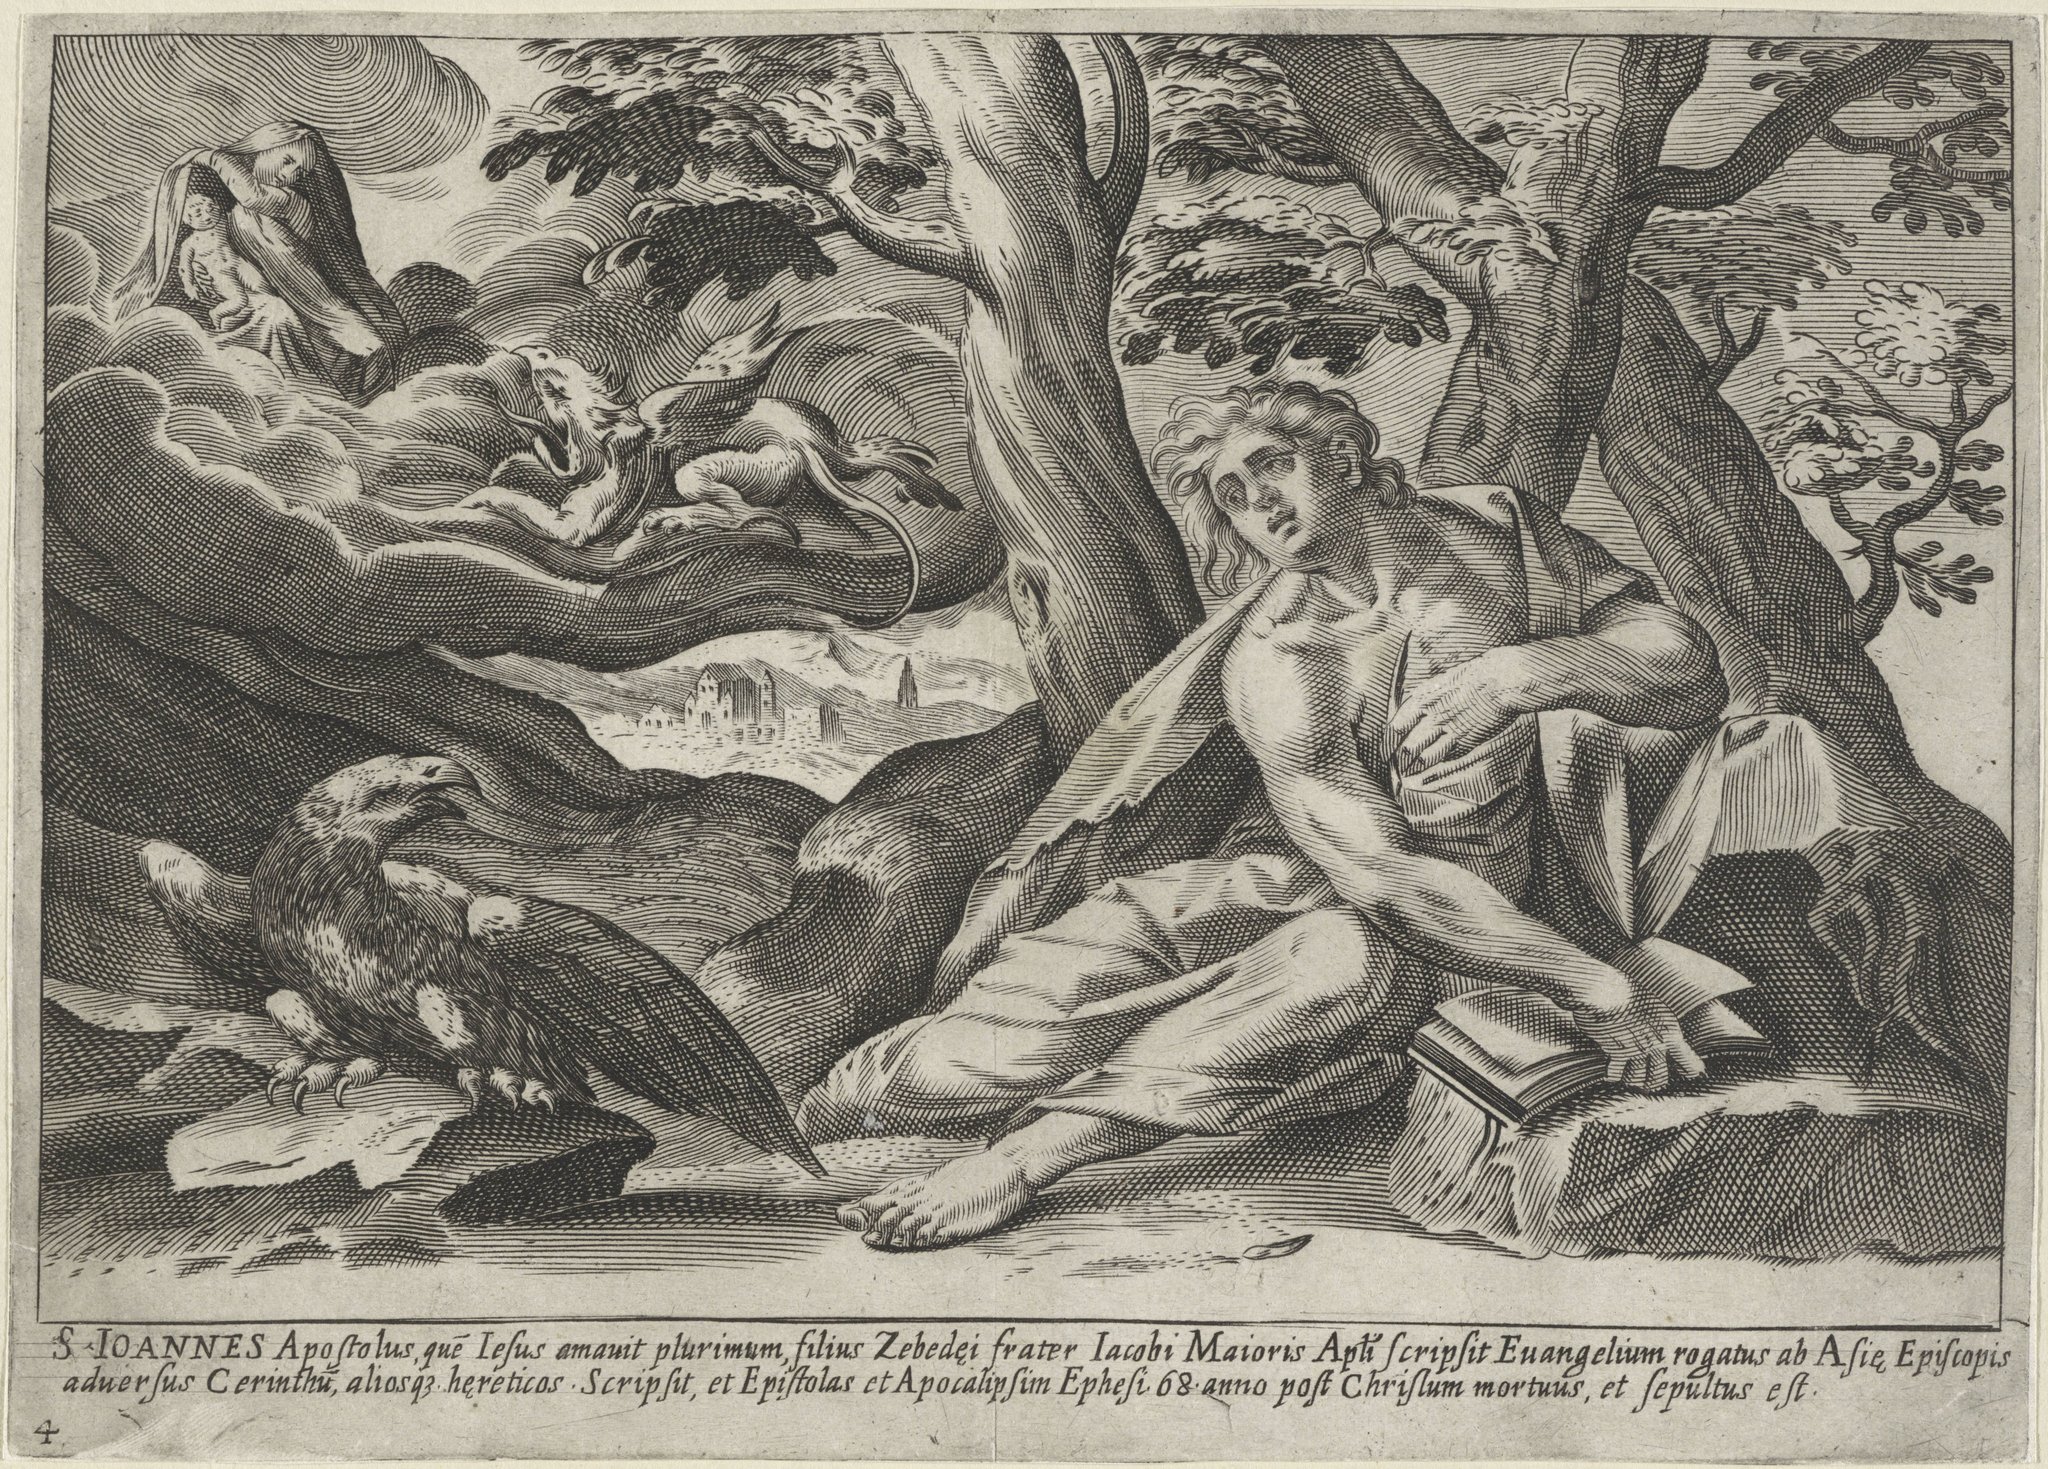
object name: print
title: Vier evangelisten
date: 1555-1642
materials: paper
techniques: engraving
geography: low countries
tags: the apostle john the evangelist; possible attributes: book, cauldron, chalice with snake, eagle, palm, scroll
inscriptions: collector's mark: Lugt 240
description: De evangelist Johannes zit als banneling onder enkele bomen op het eiland Patmos. In zijn linkerhand heeft hij een schrijfveer en onder zijn rechterhand ligt het boek Openbaring. Naast hem zit een adelaar als symbool van zijn inspiratie. Achter hem is het visioen van Maria met het Christuskind te zien. Onder de voorstelling een tweeregelige, Latijnse tekst.